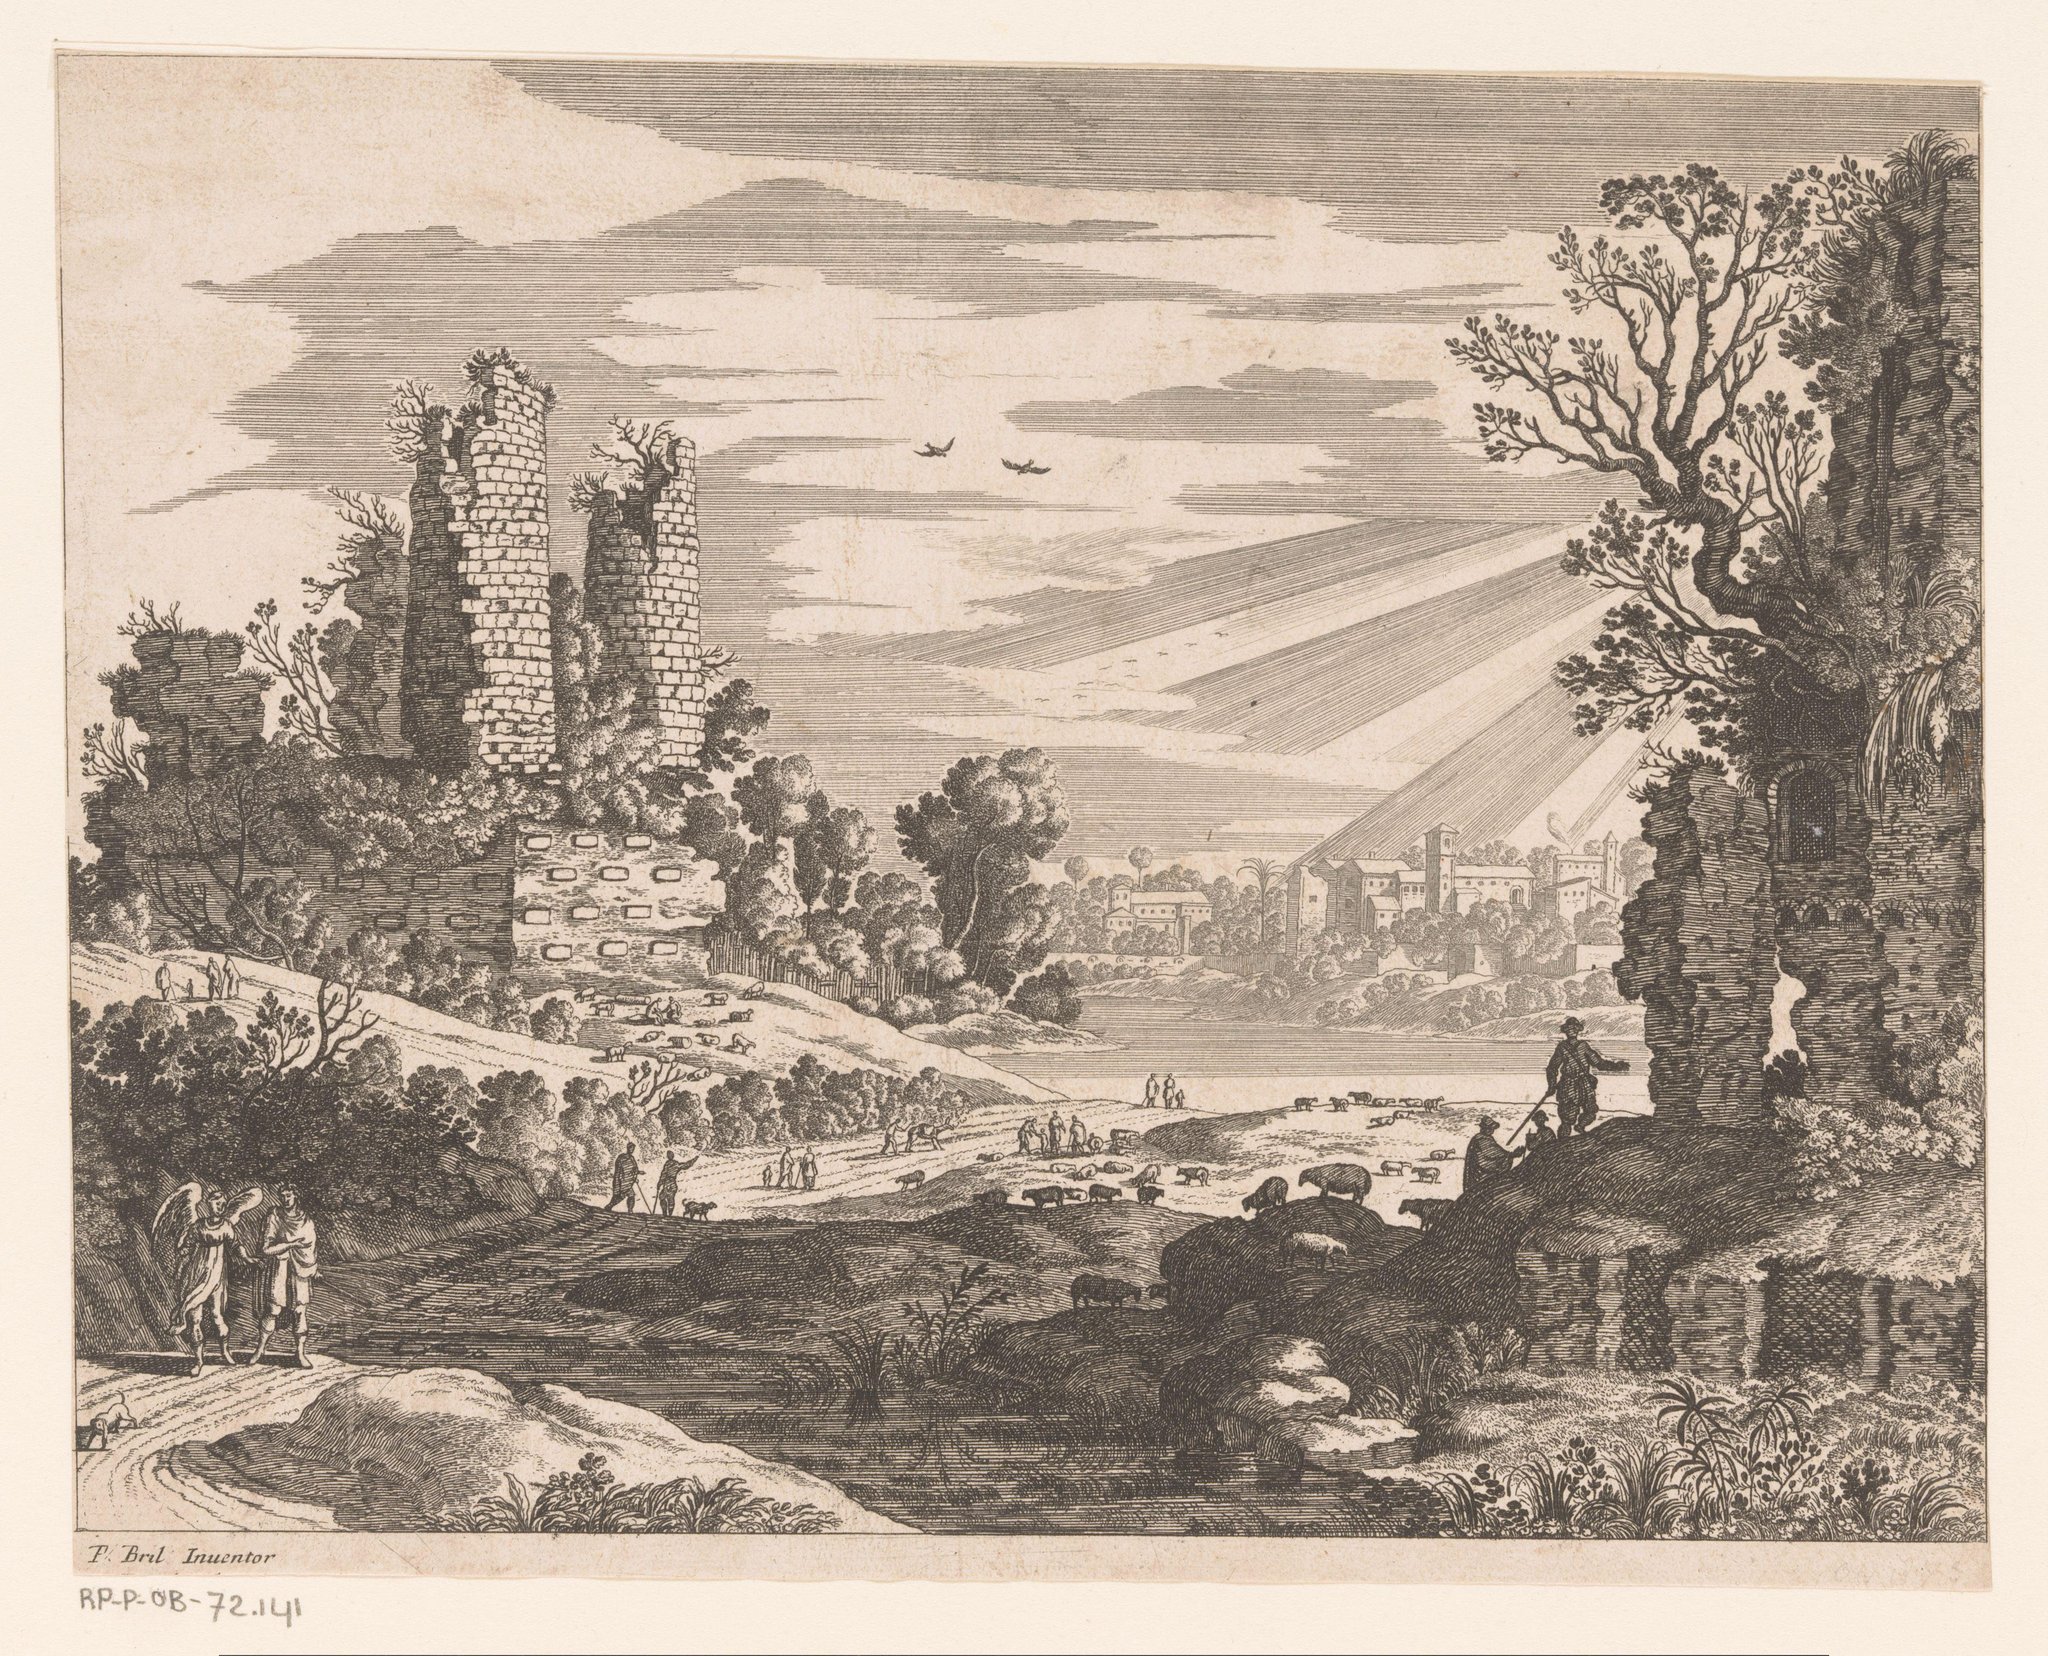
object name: print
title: Italiaans landschap met Tobias en de engel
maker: paul bril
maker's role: draughtsman, print maker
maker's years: 1554-1626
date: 1613-1695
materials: paper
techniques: engraving, etching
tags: landscapes, herd, flock, angels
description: Prenten met het signatuur 'Perelle' kunnen zowel door vader Gabriel als door zonen Nicolas en Adam gemaakt zijn.